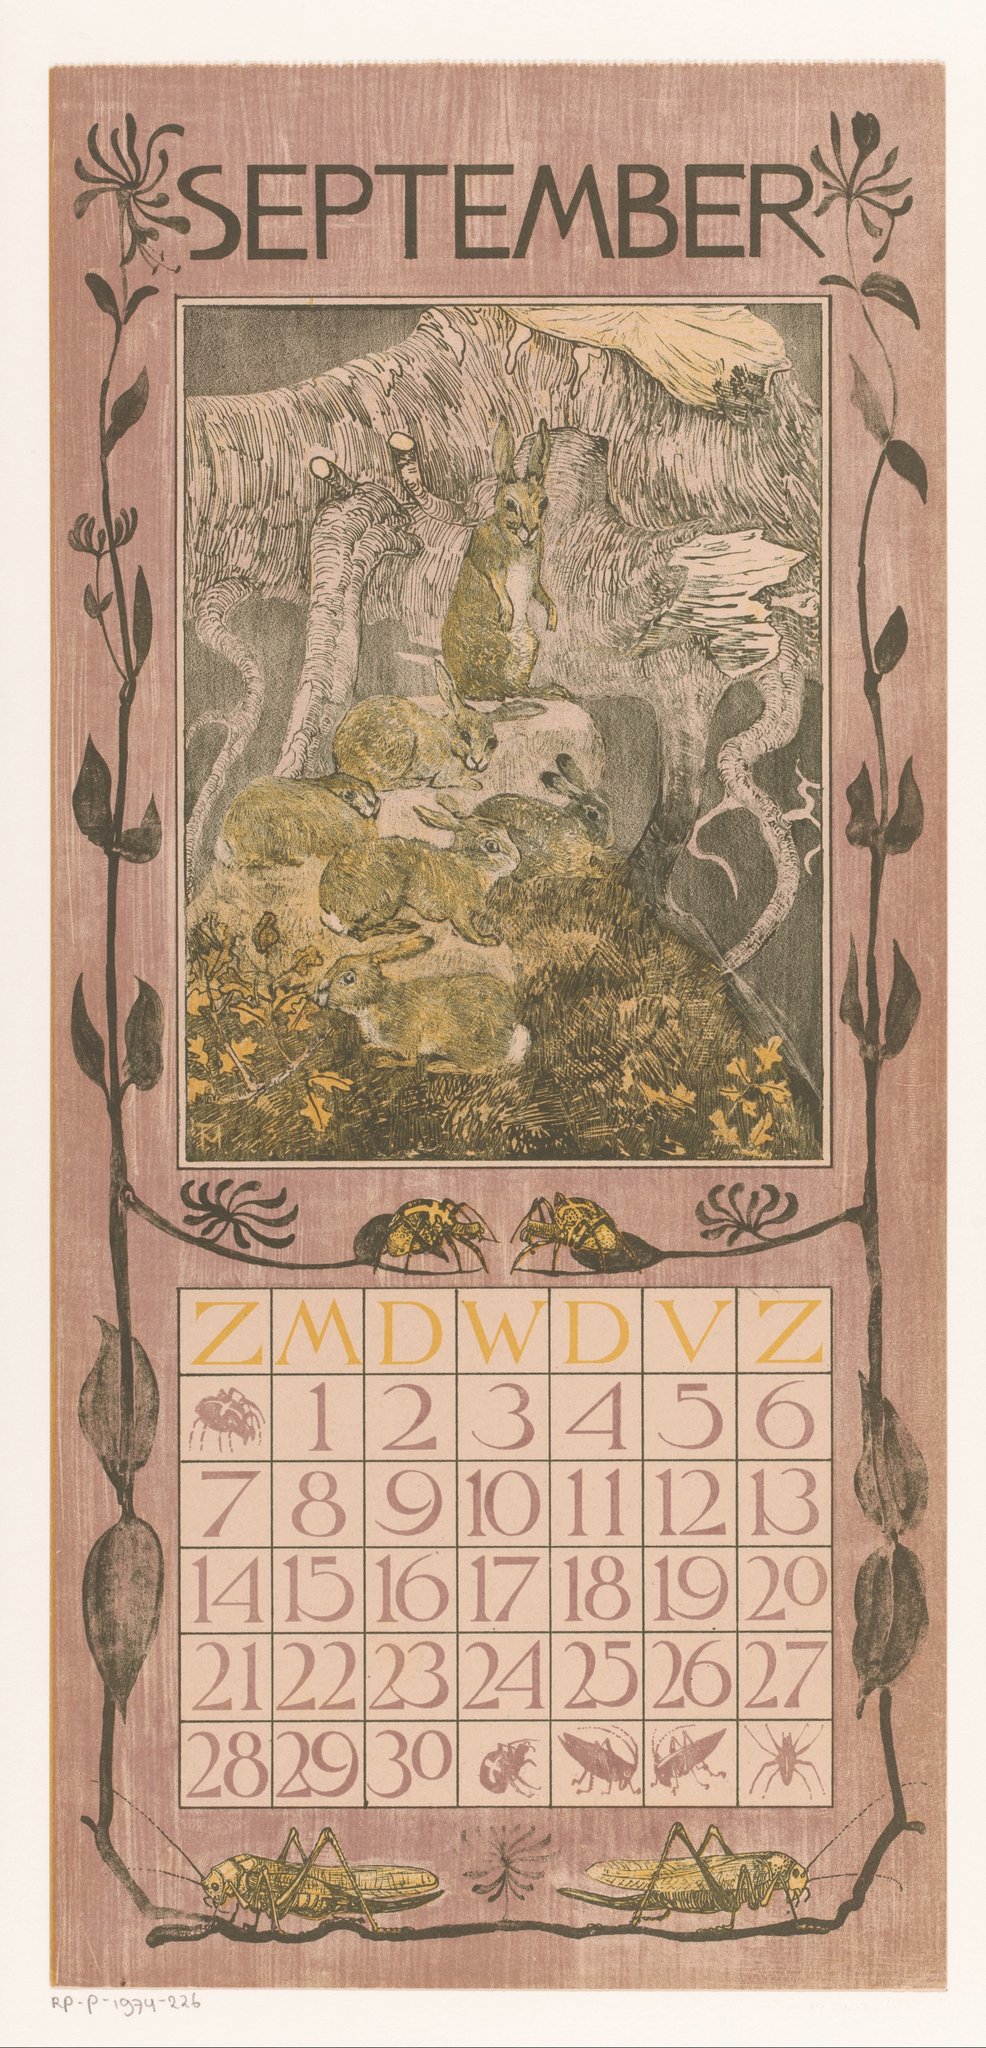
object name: print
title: Kalender 1902 12 lithografien door Th. v. Hoytema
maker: theo van hoytema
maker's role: draughtsman, painter, print maker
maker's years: 1863-1917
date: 1901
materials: paper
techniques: lithograph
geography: hilversum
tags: spiders, september ~ other concepts, insects: grass-hopper, rodents: rabbit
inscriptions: collector's mark: Lugt 2228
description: Ook de andere bladen van deze kalender bevinden zich de collectie, zie nummers RP-P-1980-88, RP-P-1980-89, RP-P-1974-219 t/m 229 en RP-P-1977-410.